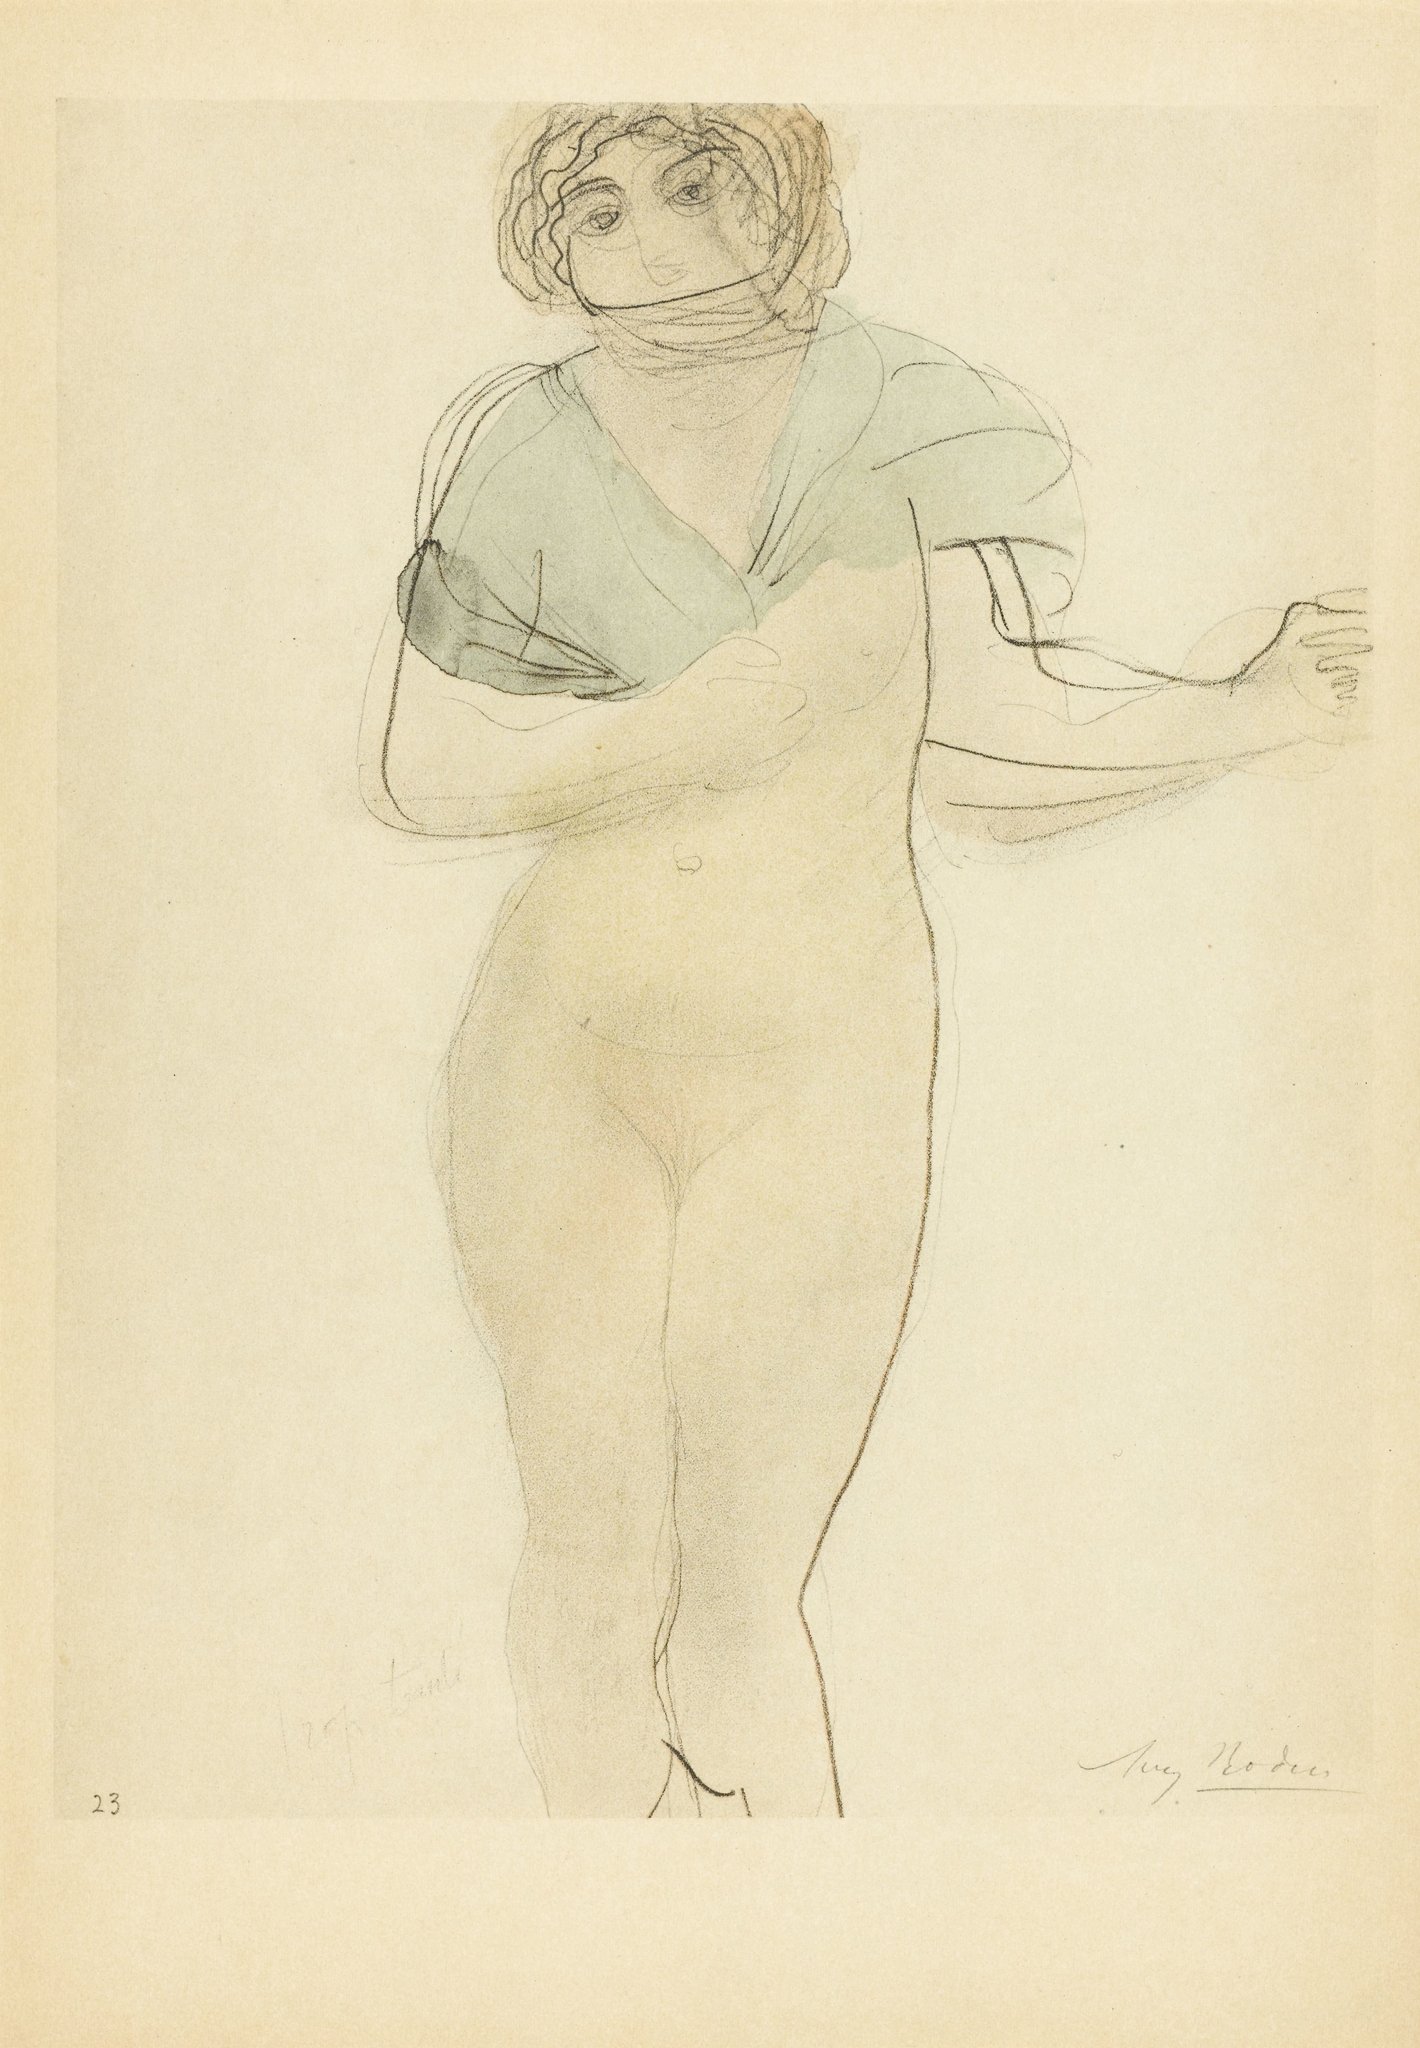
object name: reproduction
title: Reproductie van een tekening door Auguste Rodin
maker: Anonymous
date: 1904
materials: paper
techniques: photoaquatint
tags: drawing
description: Pagina uit Camera Work van Edward Stieglitz.